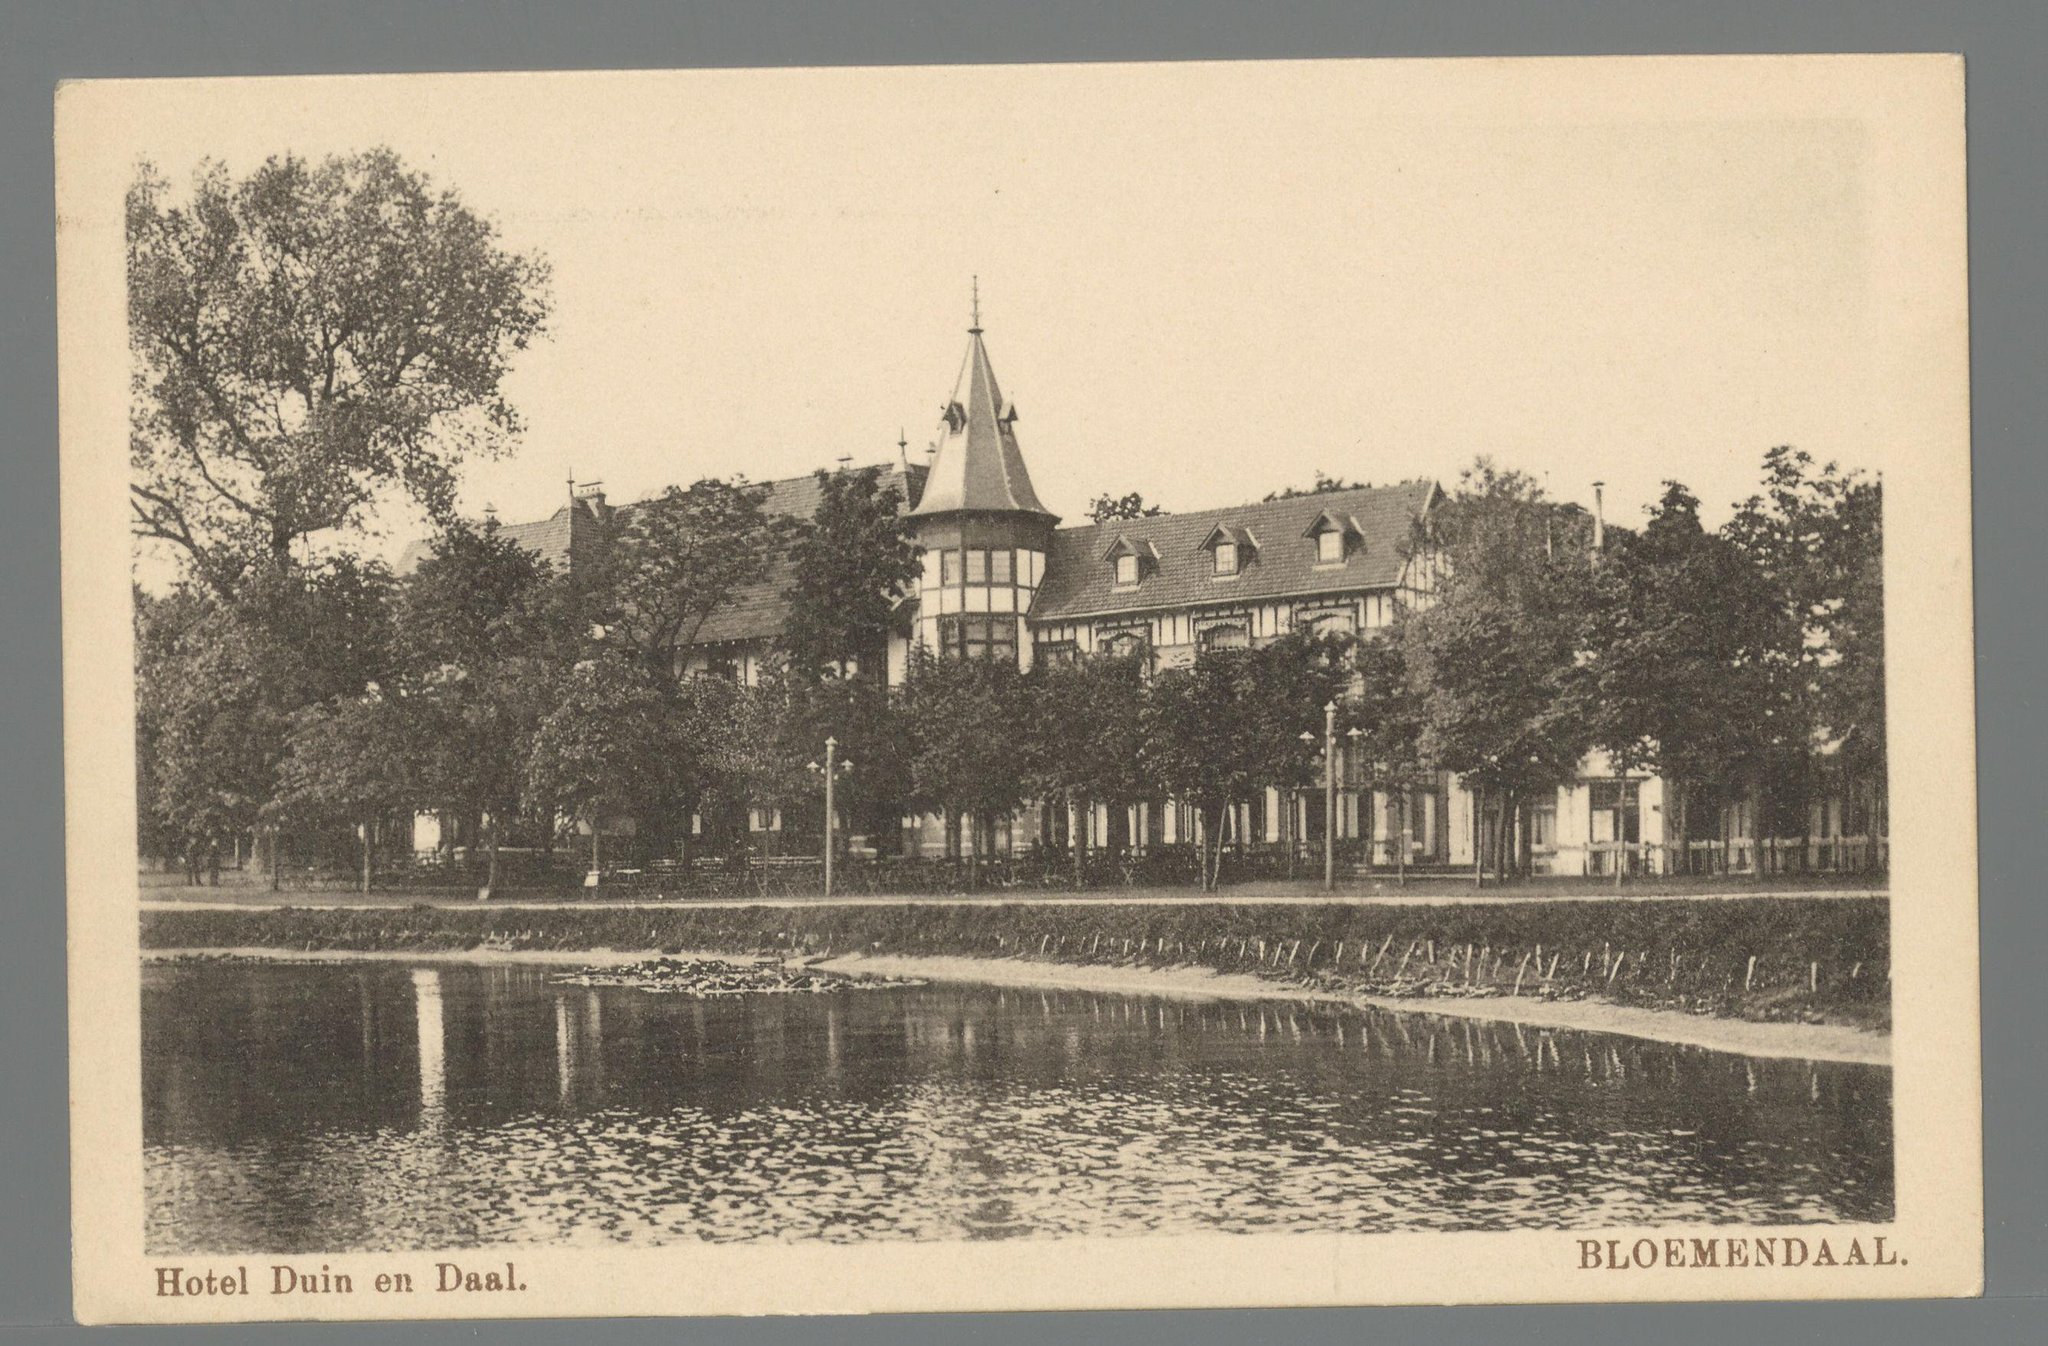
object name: ansichtkaart, prentbriefkaart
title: Hotel Duin en Daal. Bloemendaal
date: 1913-1919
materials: cardboard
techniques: photograph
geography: bloemendaal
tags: city-view, and landscape with man-made constructions, hotel, hostelry, inn